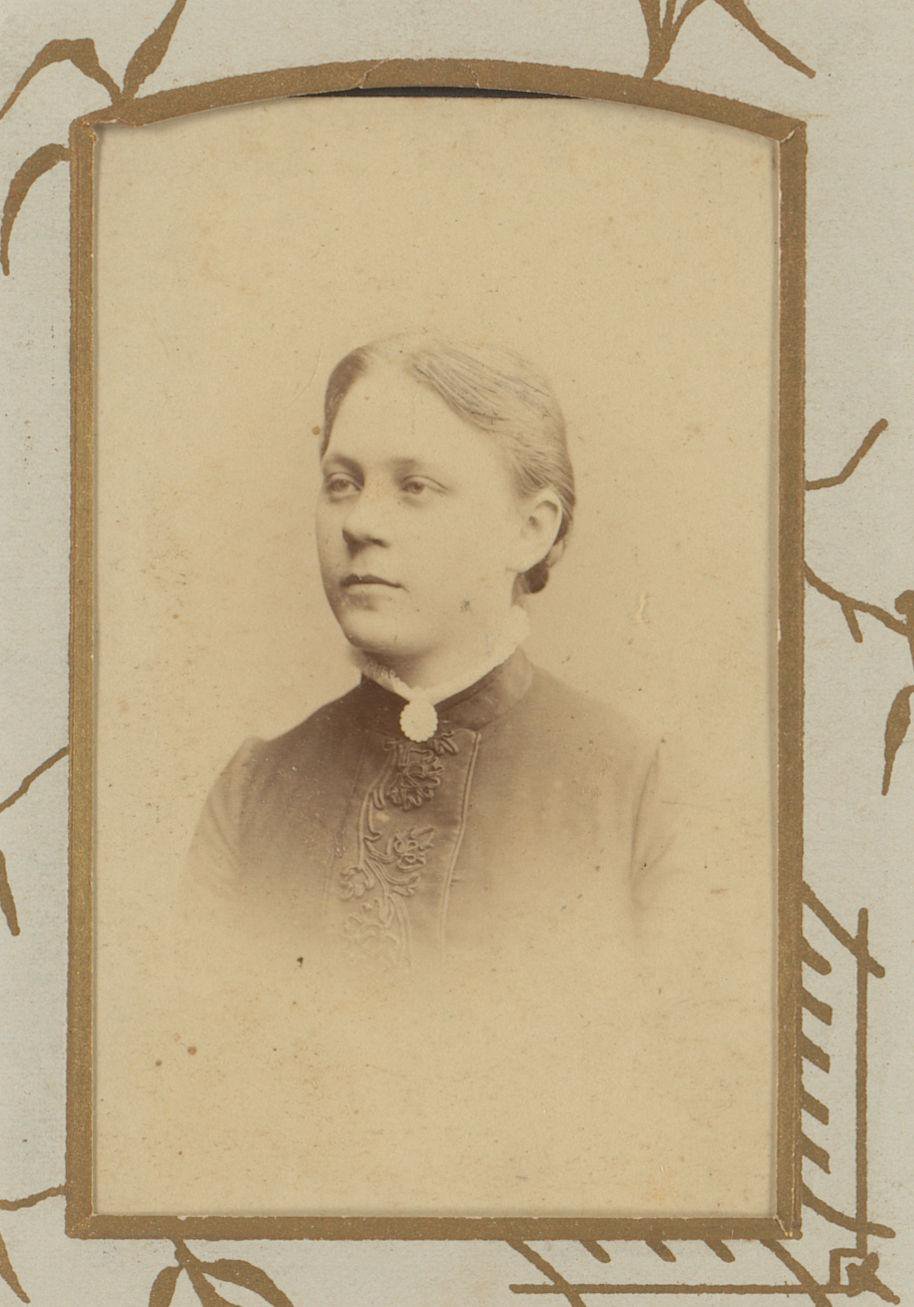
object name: carte de visite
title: Portret van een jonge vrouw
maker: ernst ulbrich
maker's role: fotograaf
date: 1860-1900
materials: cardboard, photographic support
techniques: albumen print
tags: adolescent, young woman, maiden, historical persons